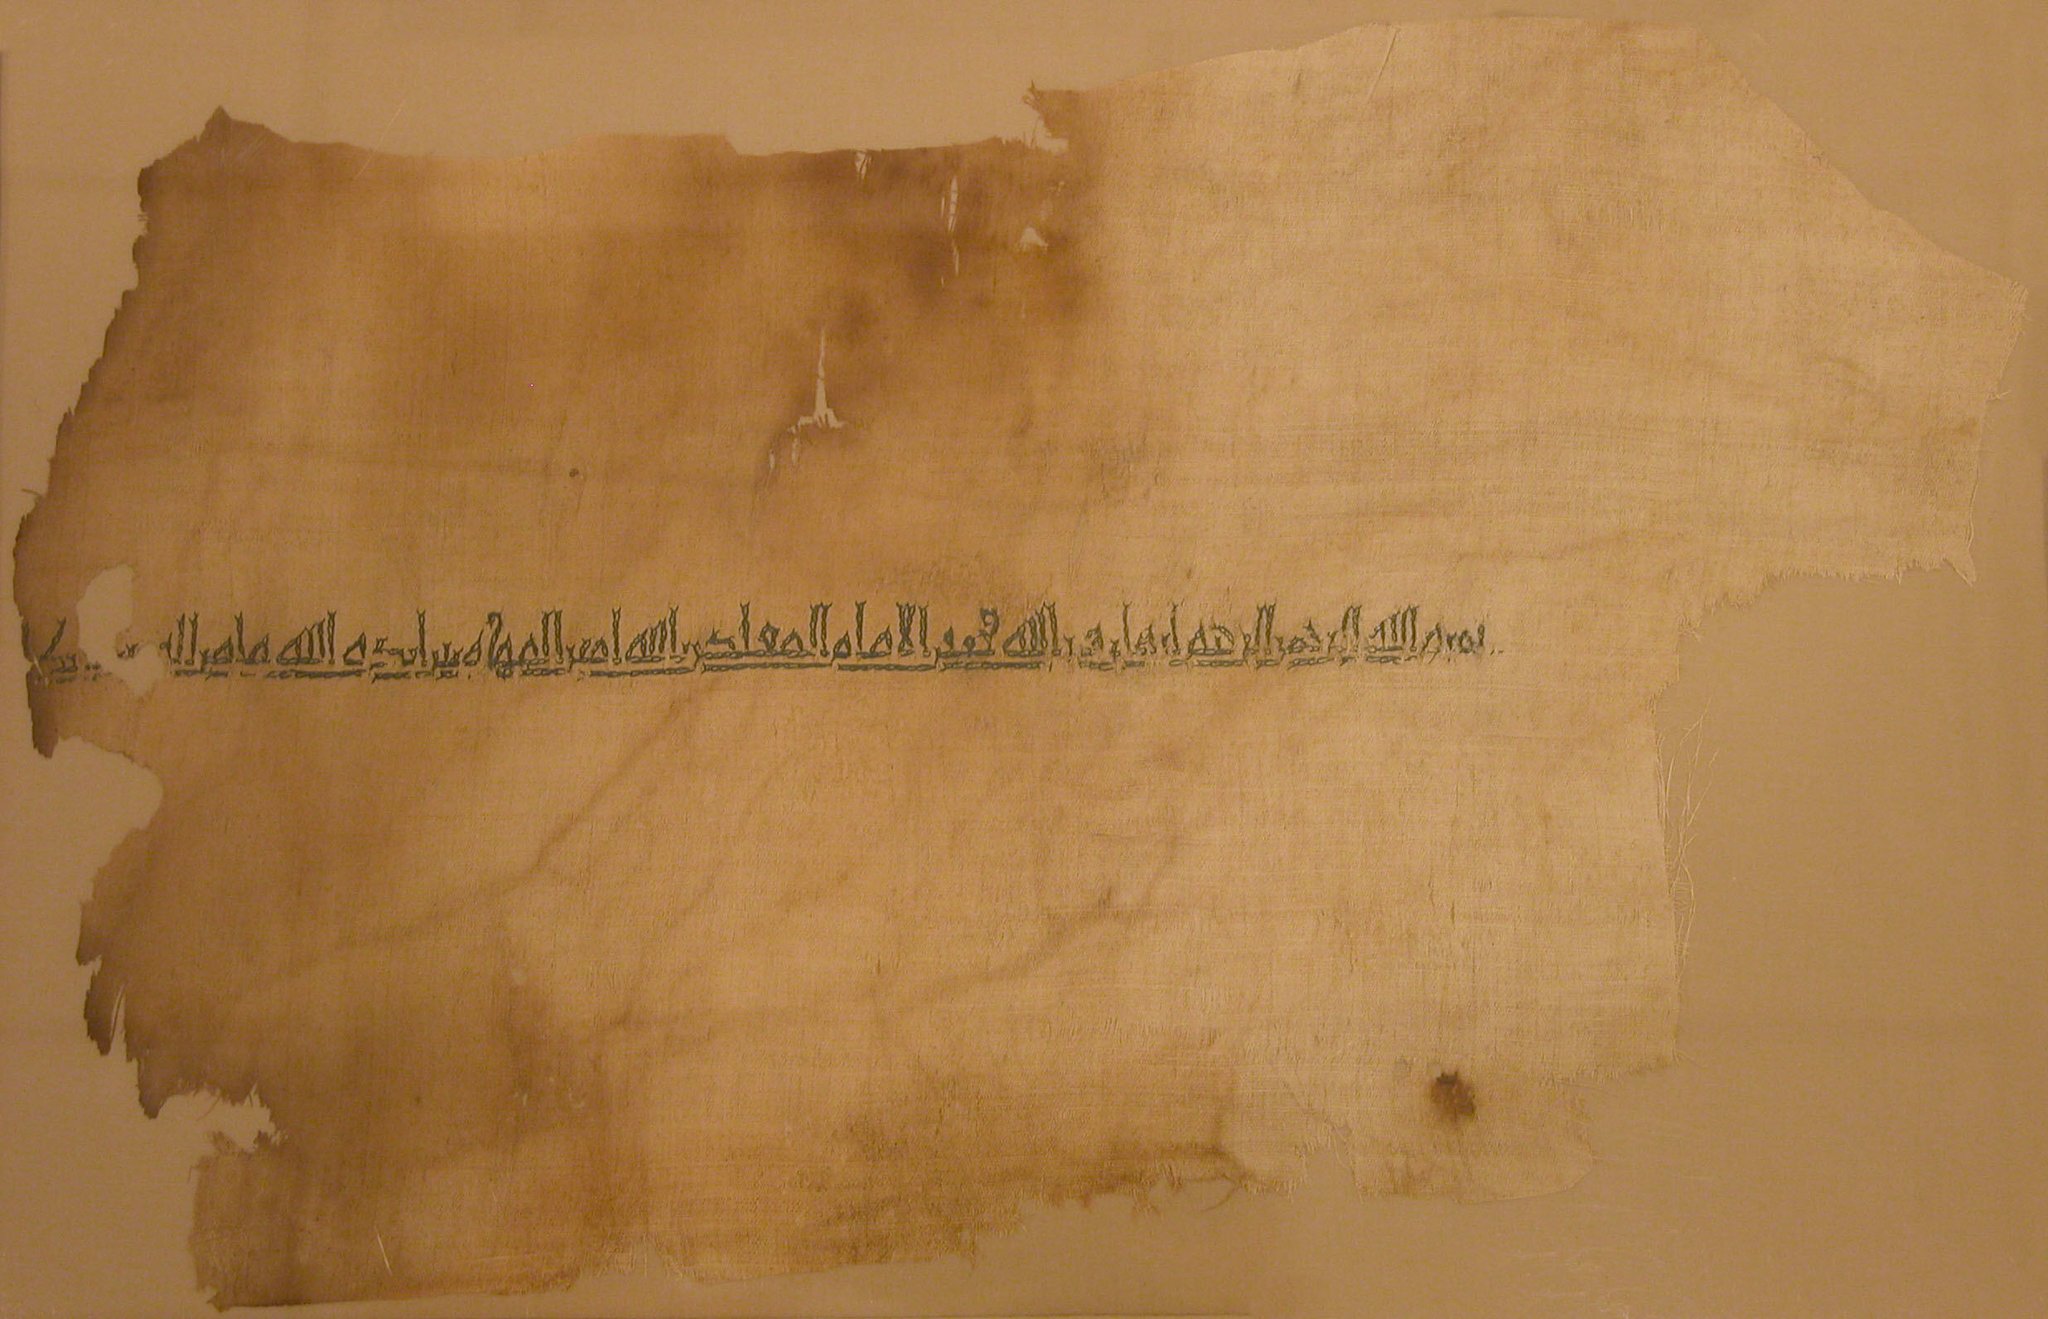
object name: textile fragment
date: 908-932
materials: linen, silk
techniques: embroidery, weave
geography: egypt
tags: arabic